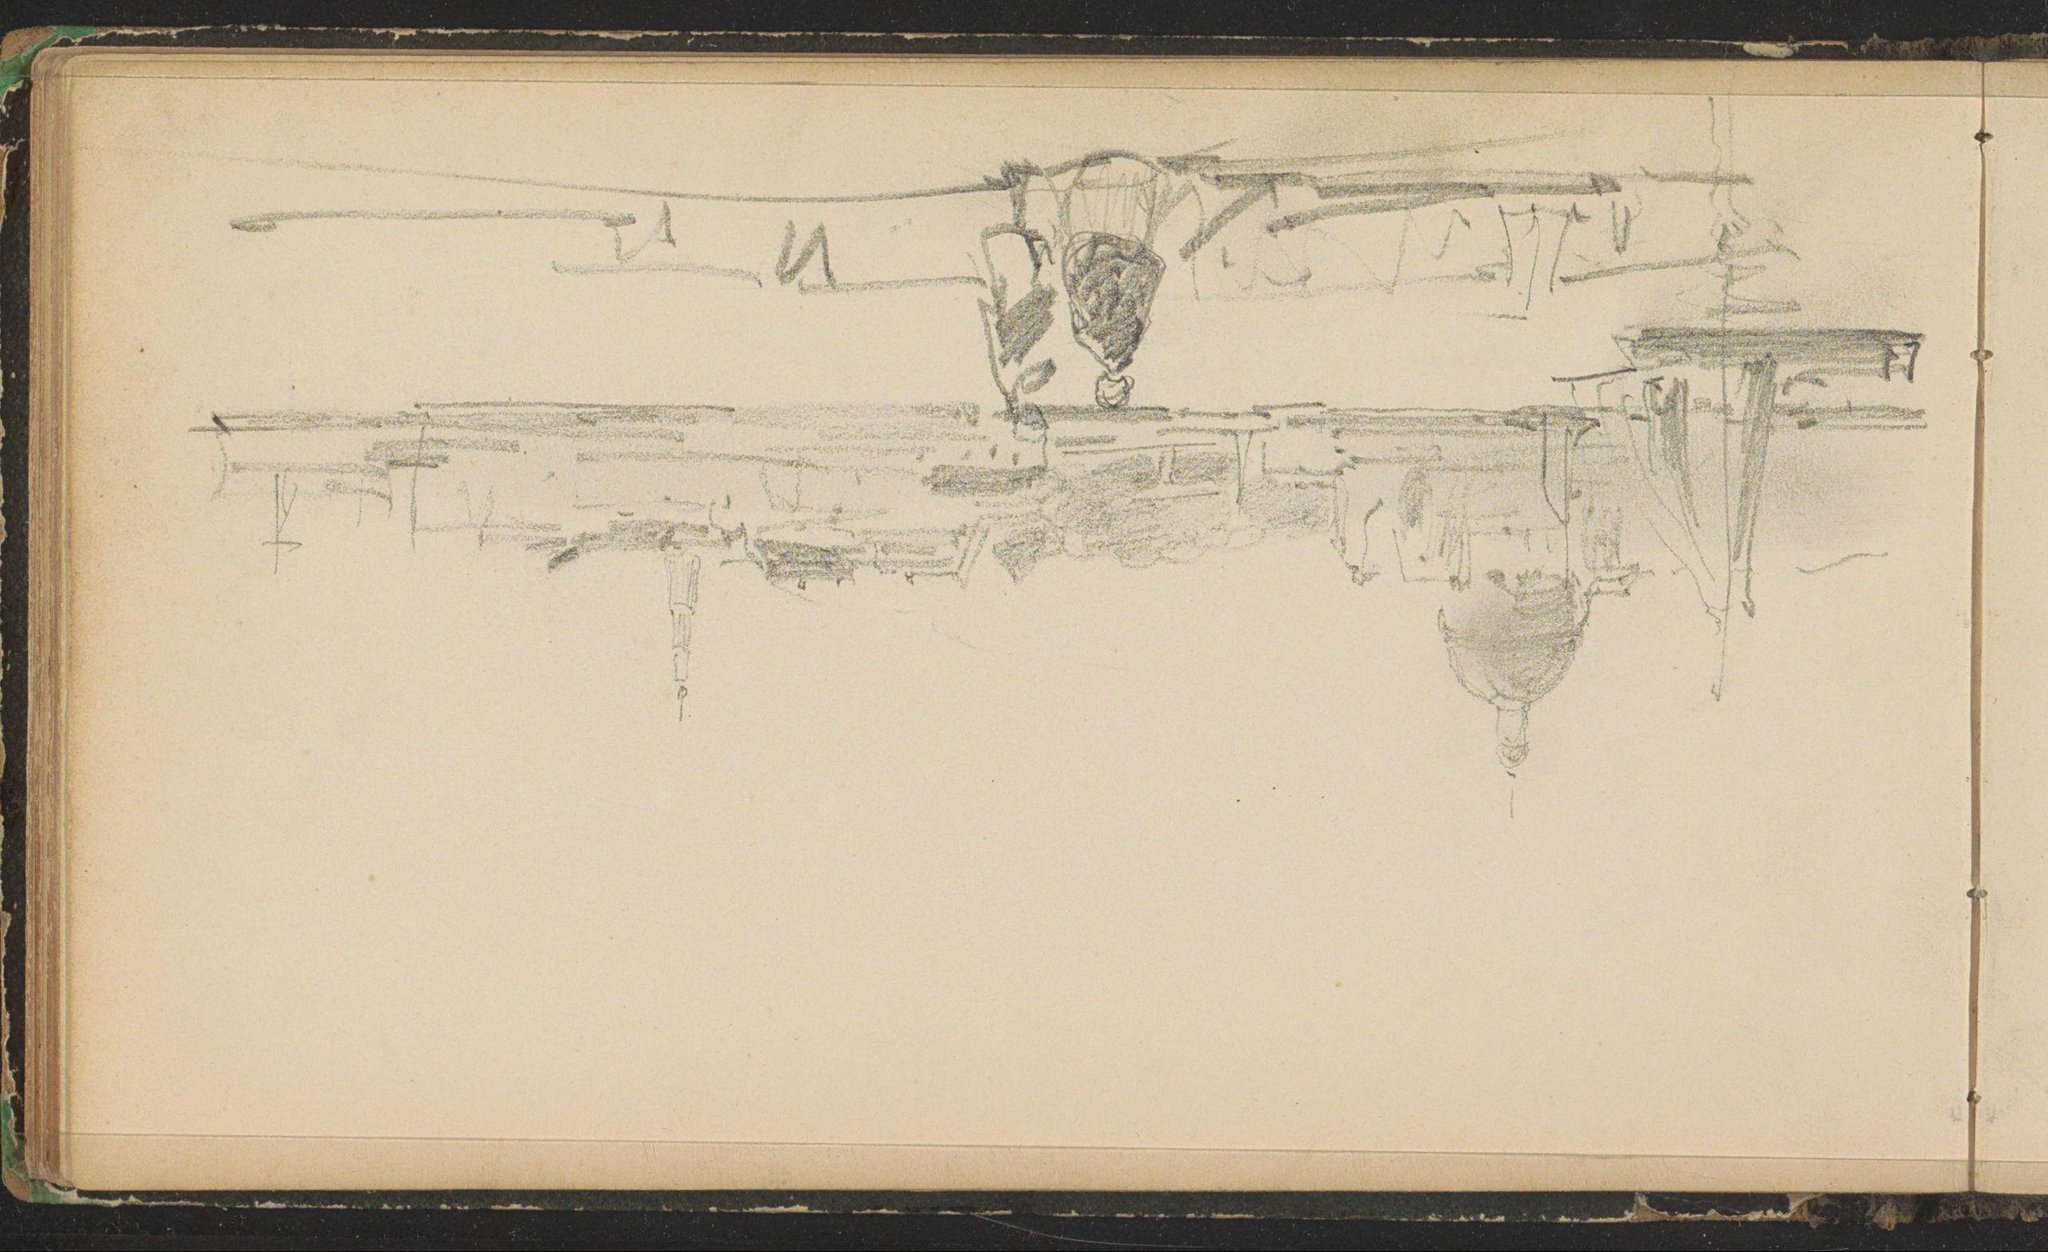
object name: sketchbook leaf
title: Twee figuren op een kade uitkijkend over een stad aan een rivier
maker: johannes bosboom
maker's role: draughtsman, painter, print maker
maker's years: 1817-1891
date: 1845-1891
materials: paper, pencil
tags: landscapes with waters, waterscapes, seascapes (in the temperate zone) (+ landscape with figures, staffage), prospect of city, town panorama, silhouette of city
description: Aan de overzijde van de rivier een gebouw met koepeldak. Op de rivier varen zeilschepen. Blad 39 verso uit een schetsboek met 46 bladen.